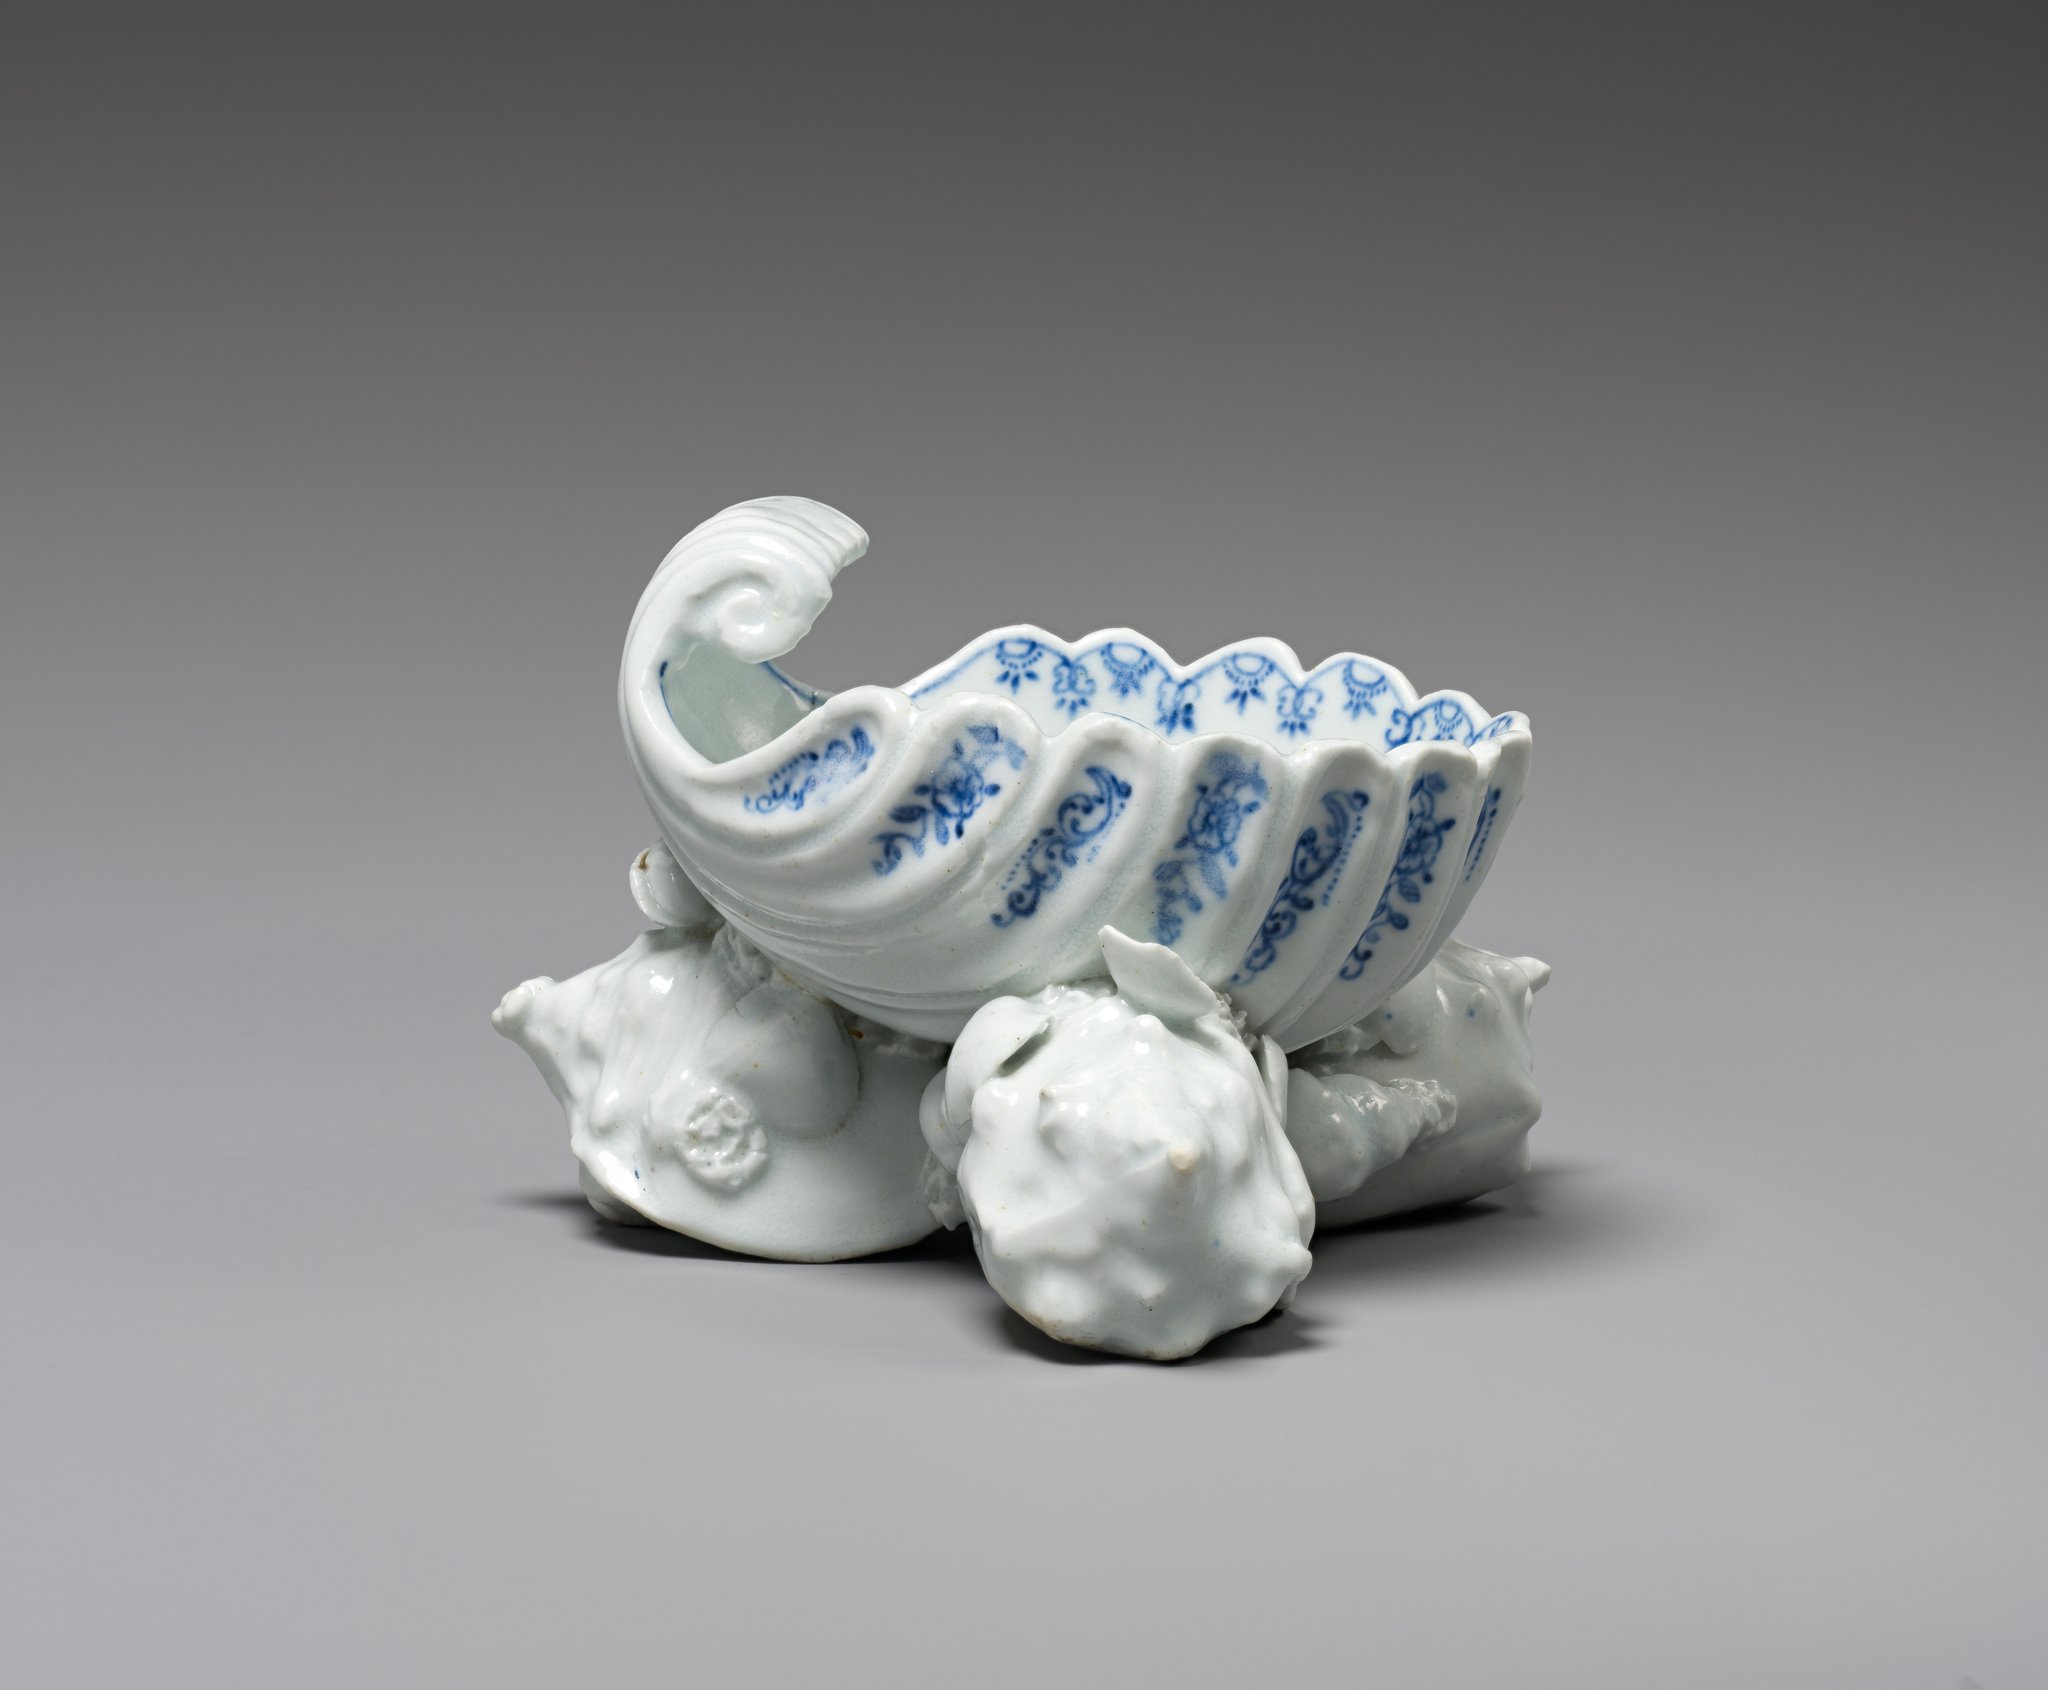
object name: sweetmeat dish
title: Sweetmeat dish (one of a pair)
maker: bow porcelain factory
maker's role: factory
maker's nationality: british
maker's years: 1747-1776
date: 1750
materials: soft paste porcelain